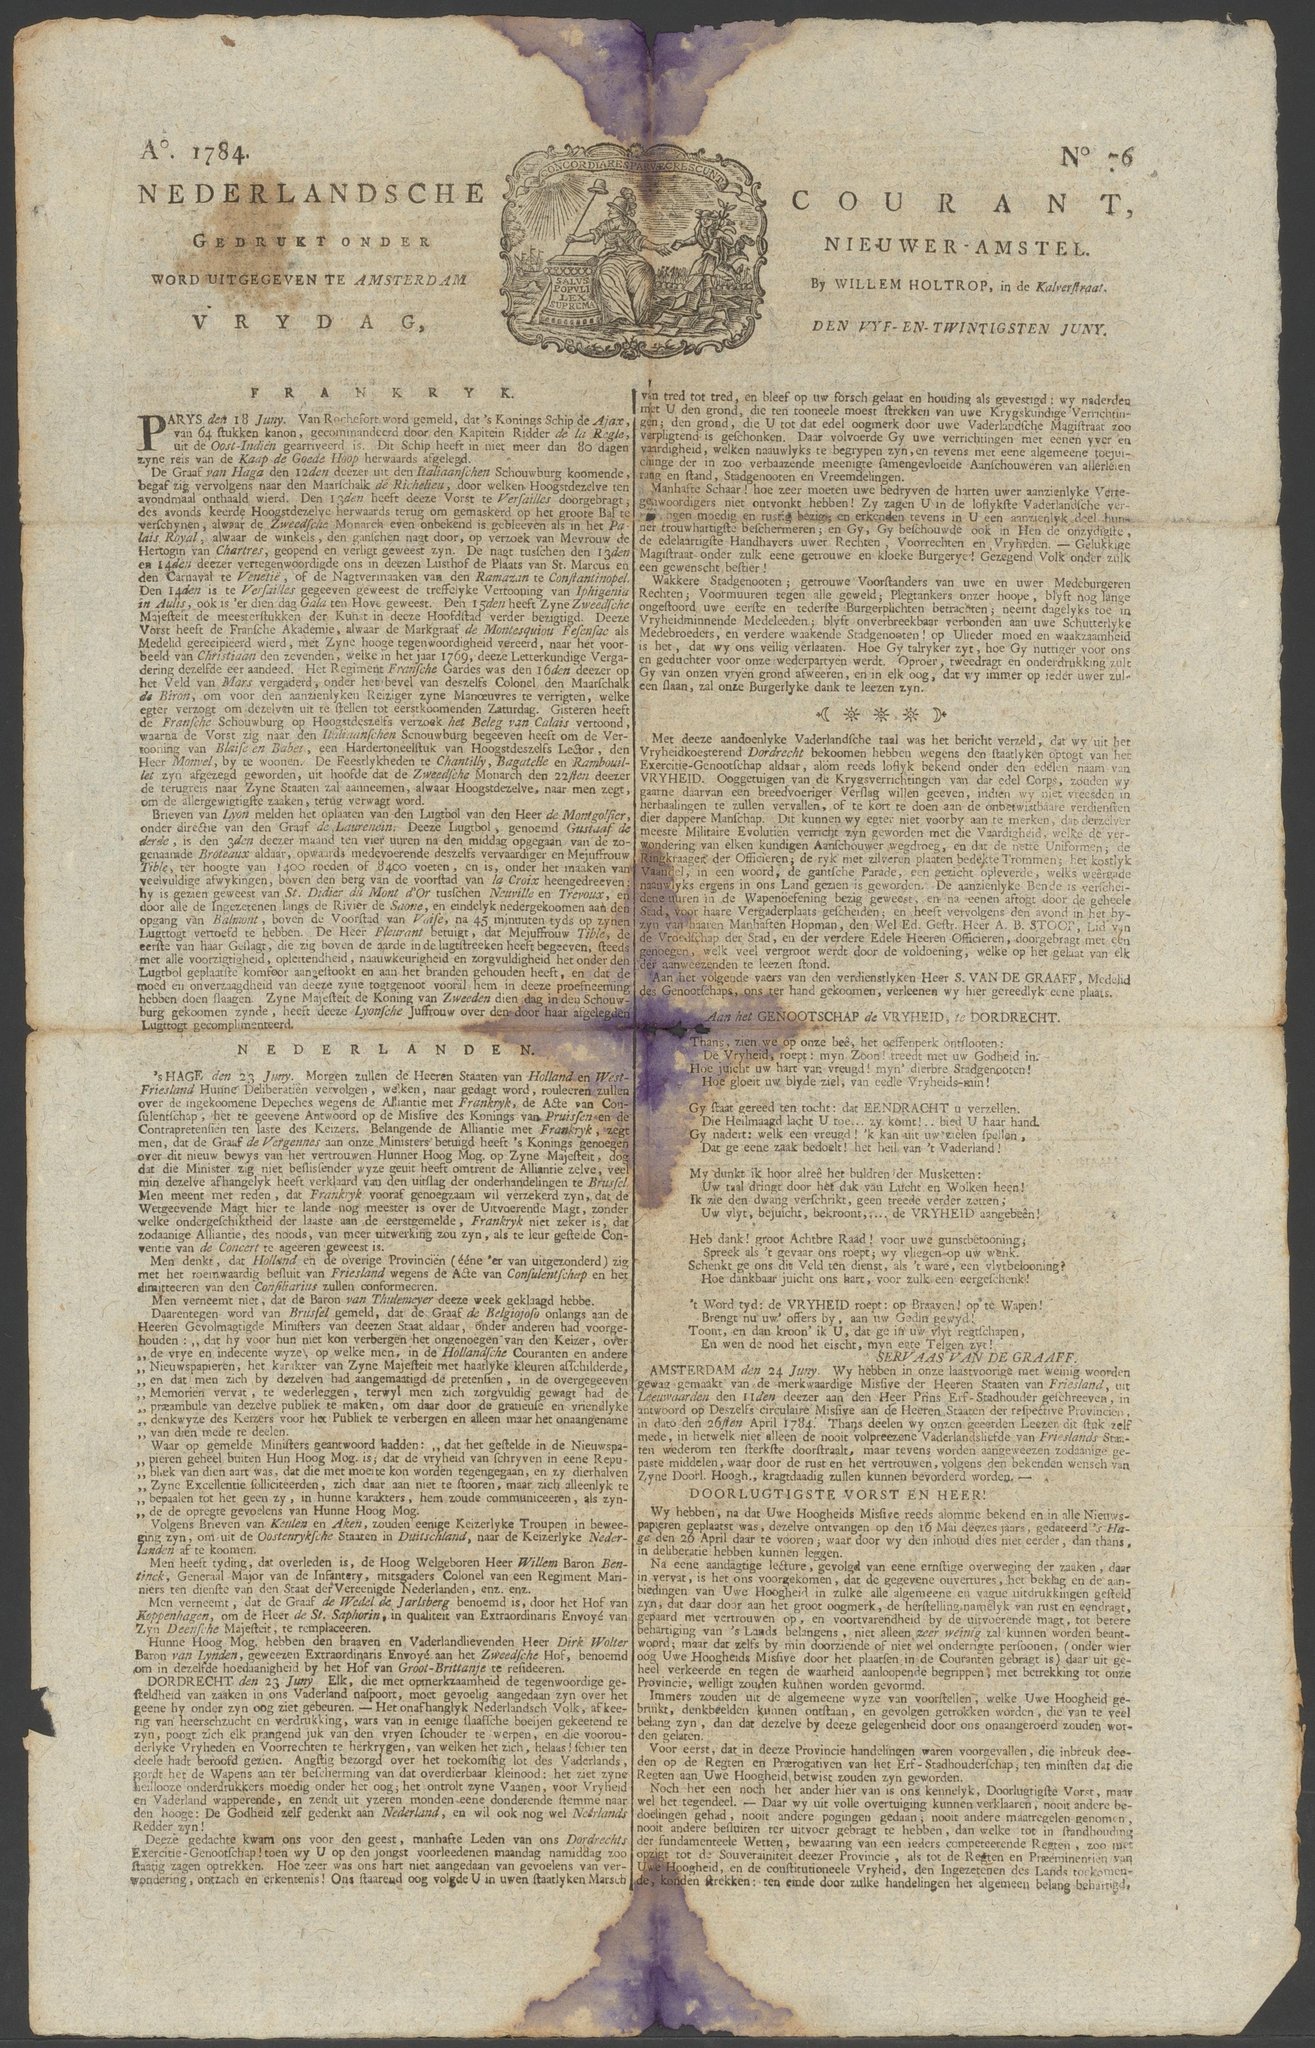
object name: newspaper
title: Nederlandsche Courant, 25 juni 1784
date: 1784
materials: paper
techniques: letterpress printing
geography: nieuwer-amstel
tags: newspaper, news-sheet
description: Exemplaar van de krant 'Nederlandsche Courant' van 25 juni 1784. Enkelbladig, beide zijden bedrukt. Bovenaan een vignet met de Vrijheid en Mercurius. Onderwerpsrubrieken binnen de Atlas Zeden en Gewoonten: Regeering, Officieele Nieuwsbladen.